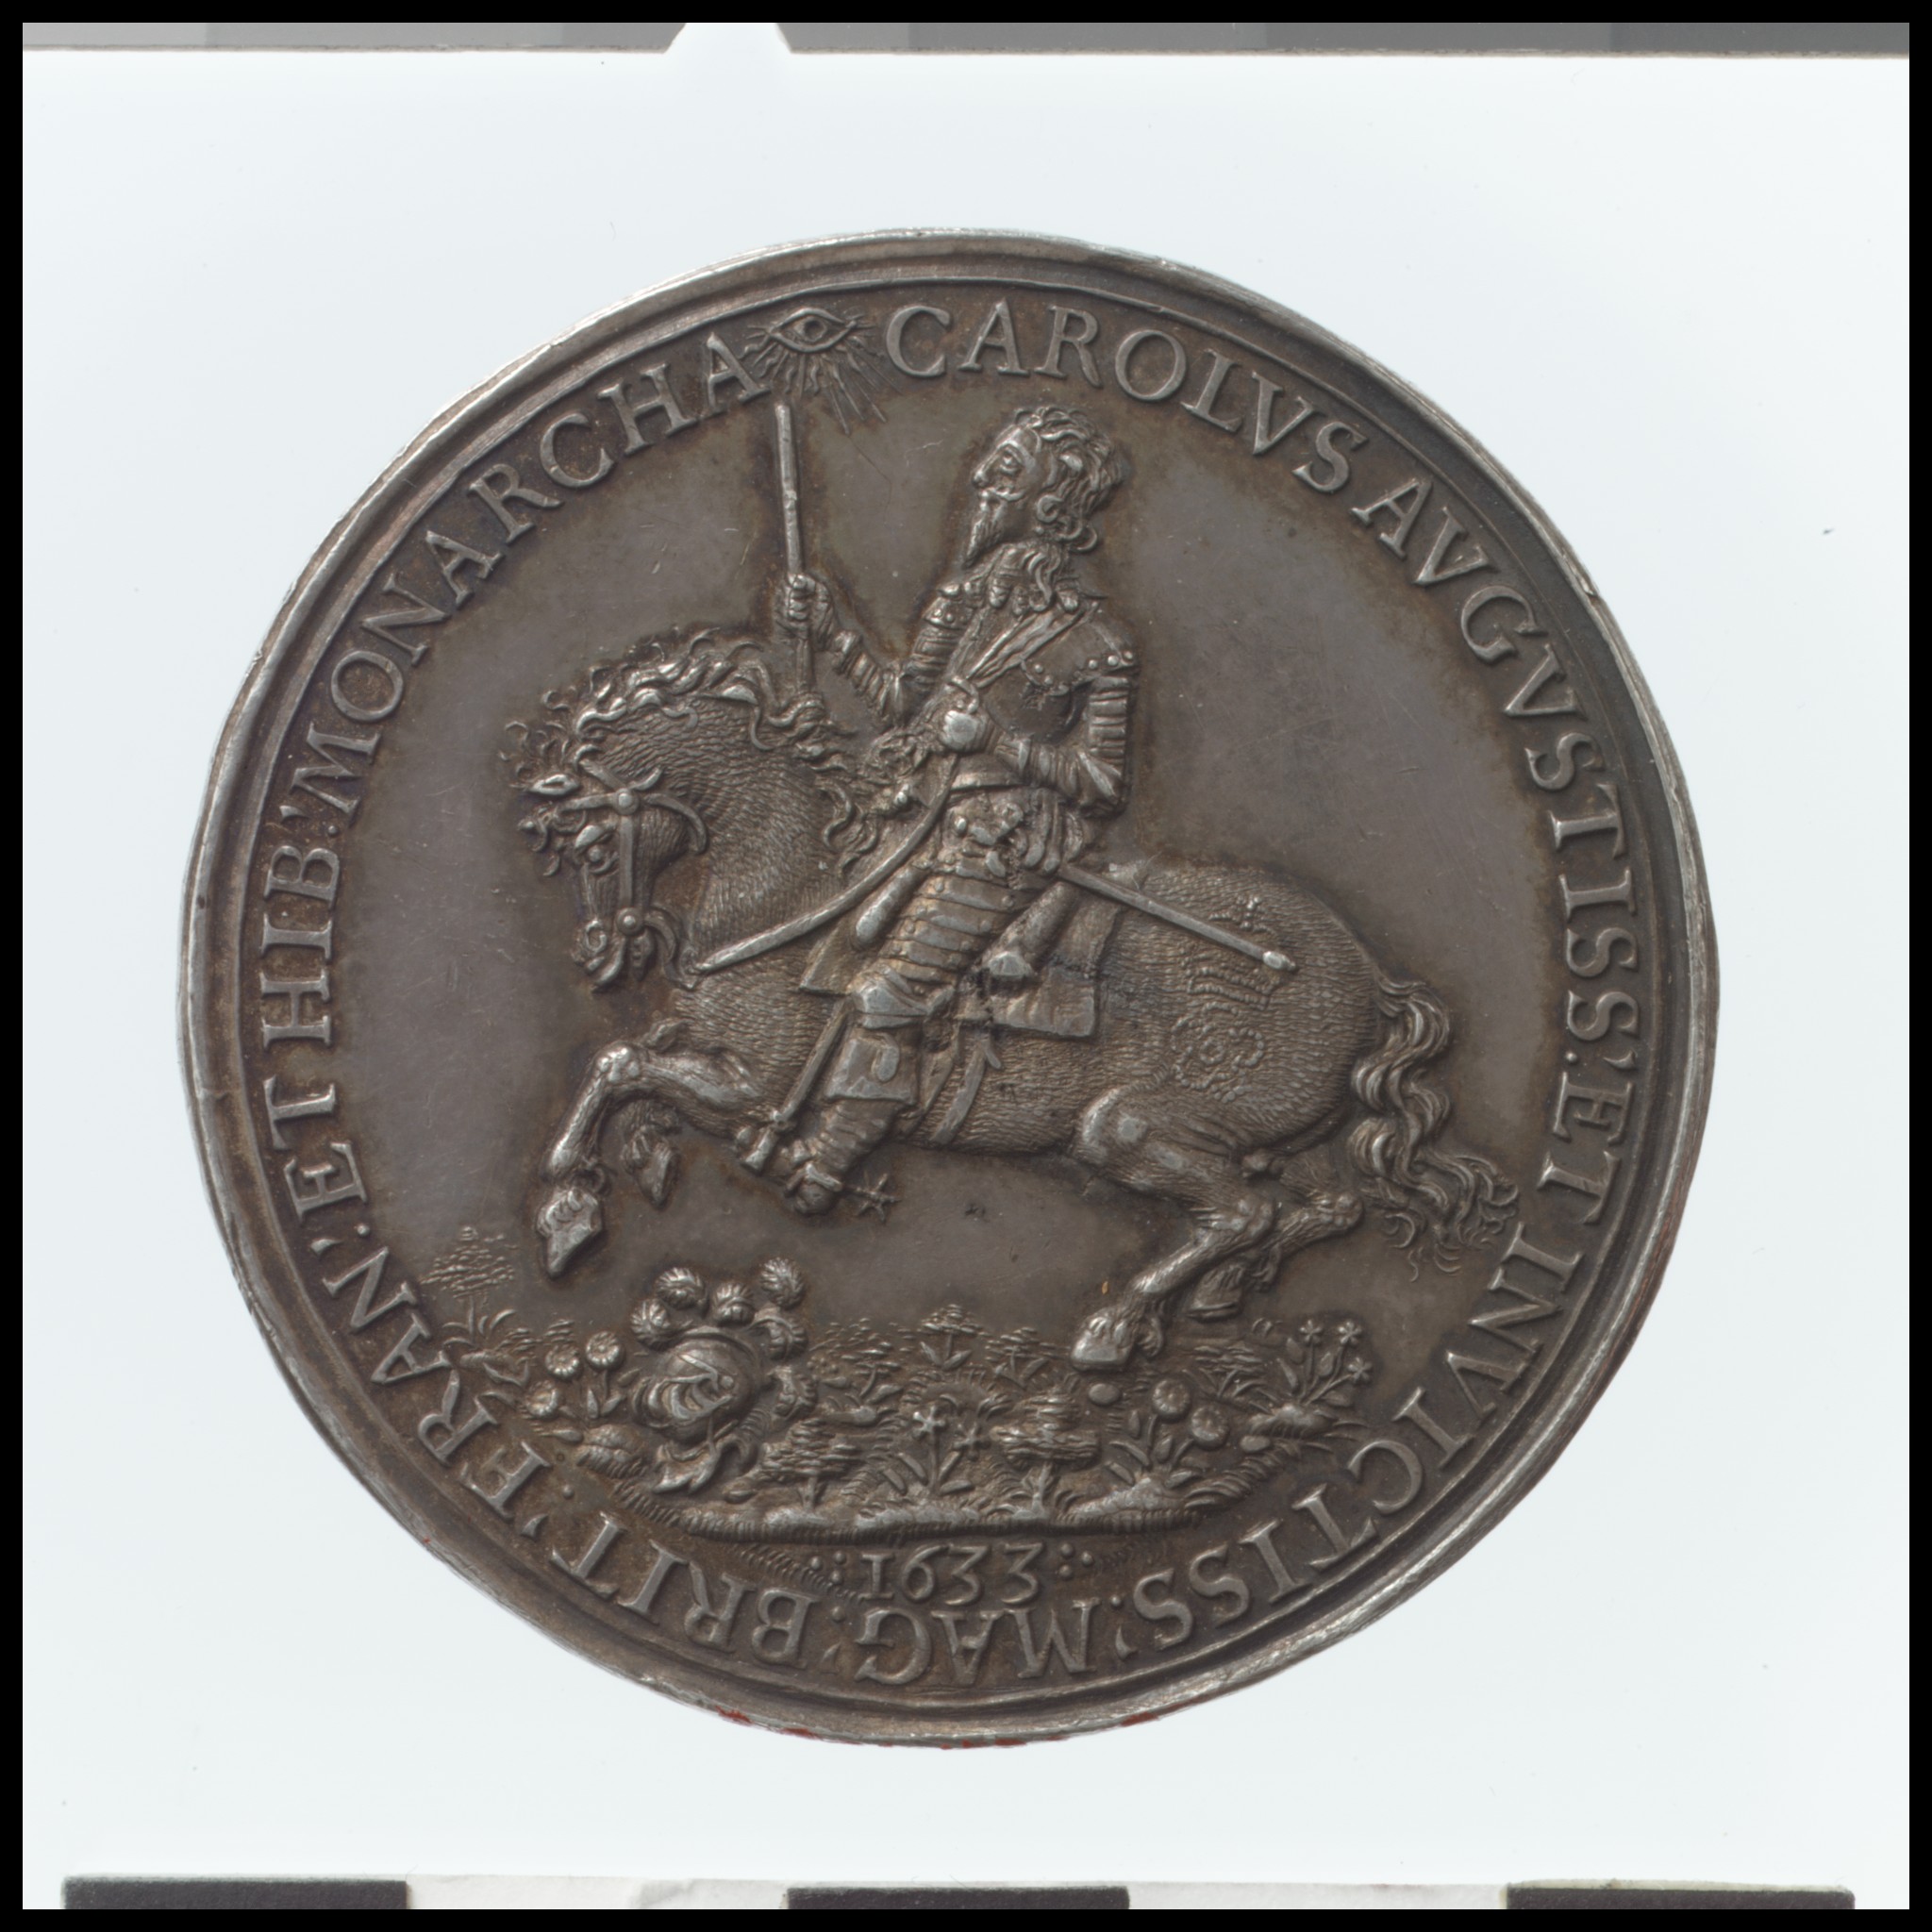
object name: medal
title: Return of Charles I to London after the Coronation at Edinburgh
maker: nicholas briot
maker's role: maker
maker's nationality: french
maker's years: 1579-1646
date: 1633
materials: silver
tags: swords,kings,horses,boats